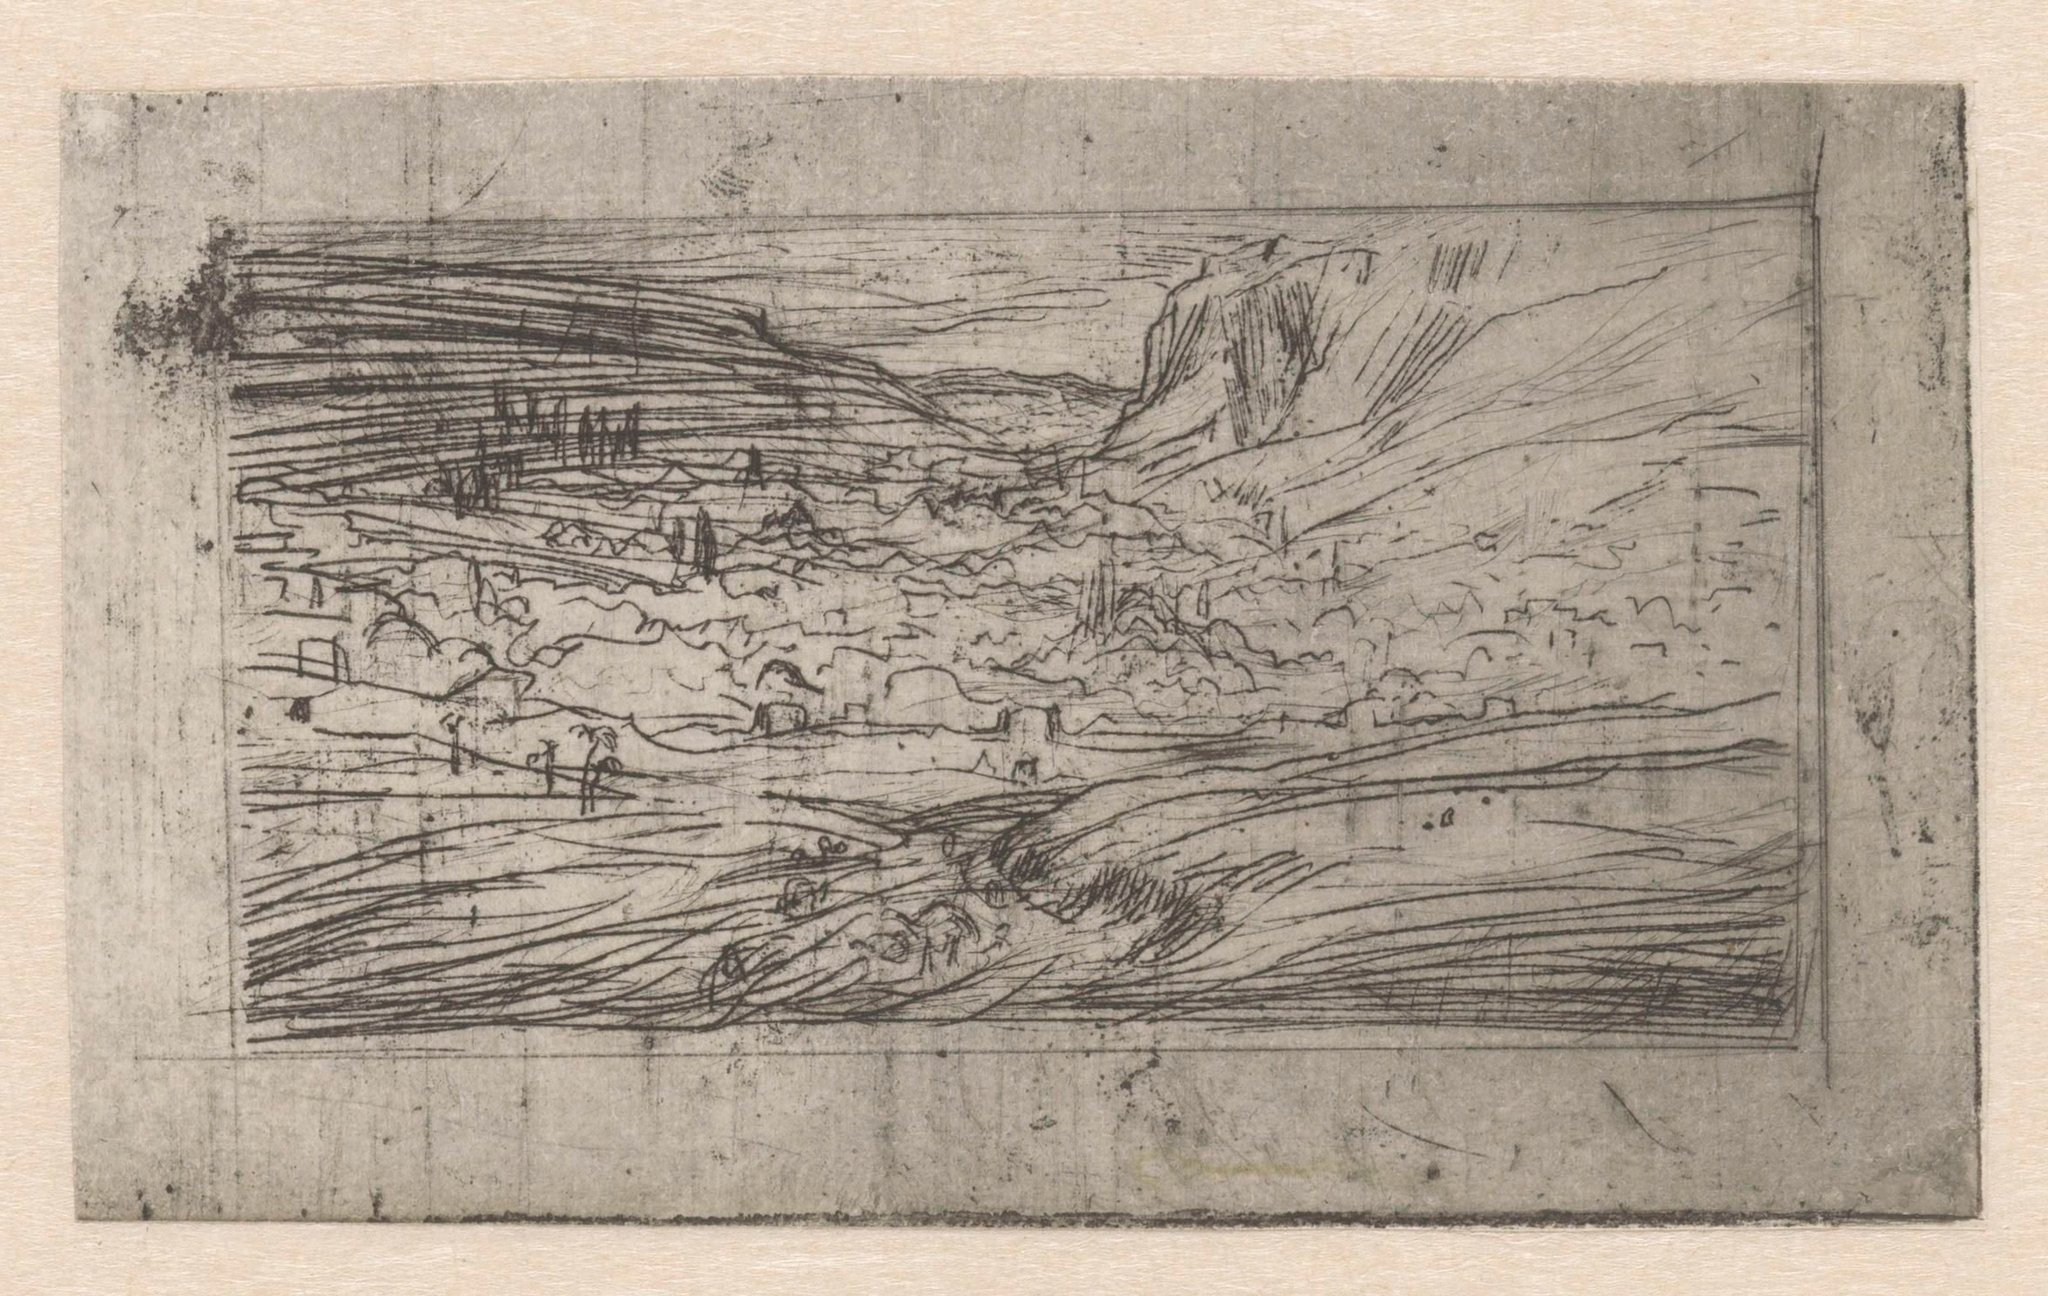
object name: print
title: UItzicht op een Ottomaanse stad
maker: marius bauer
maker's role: draughtsman, print maker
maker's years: 1867-1932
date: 1889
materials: paper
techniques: etching, intaglio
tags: city-view in general; 'veduta'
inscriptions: collector's mark: Lugt 2228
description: Uitzicht op een Ottomaanse stad gelegen in een dal.